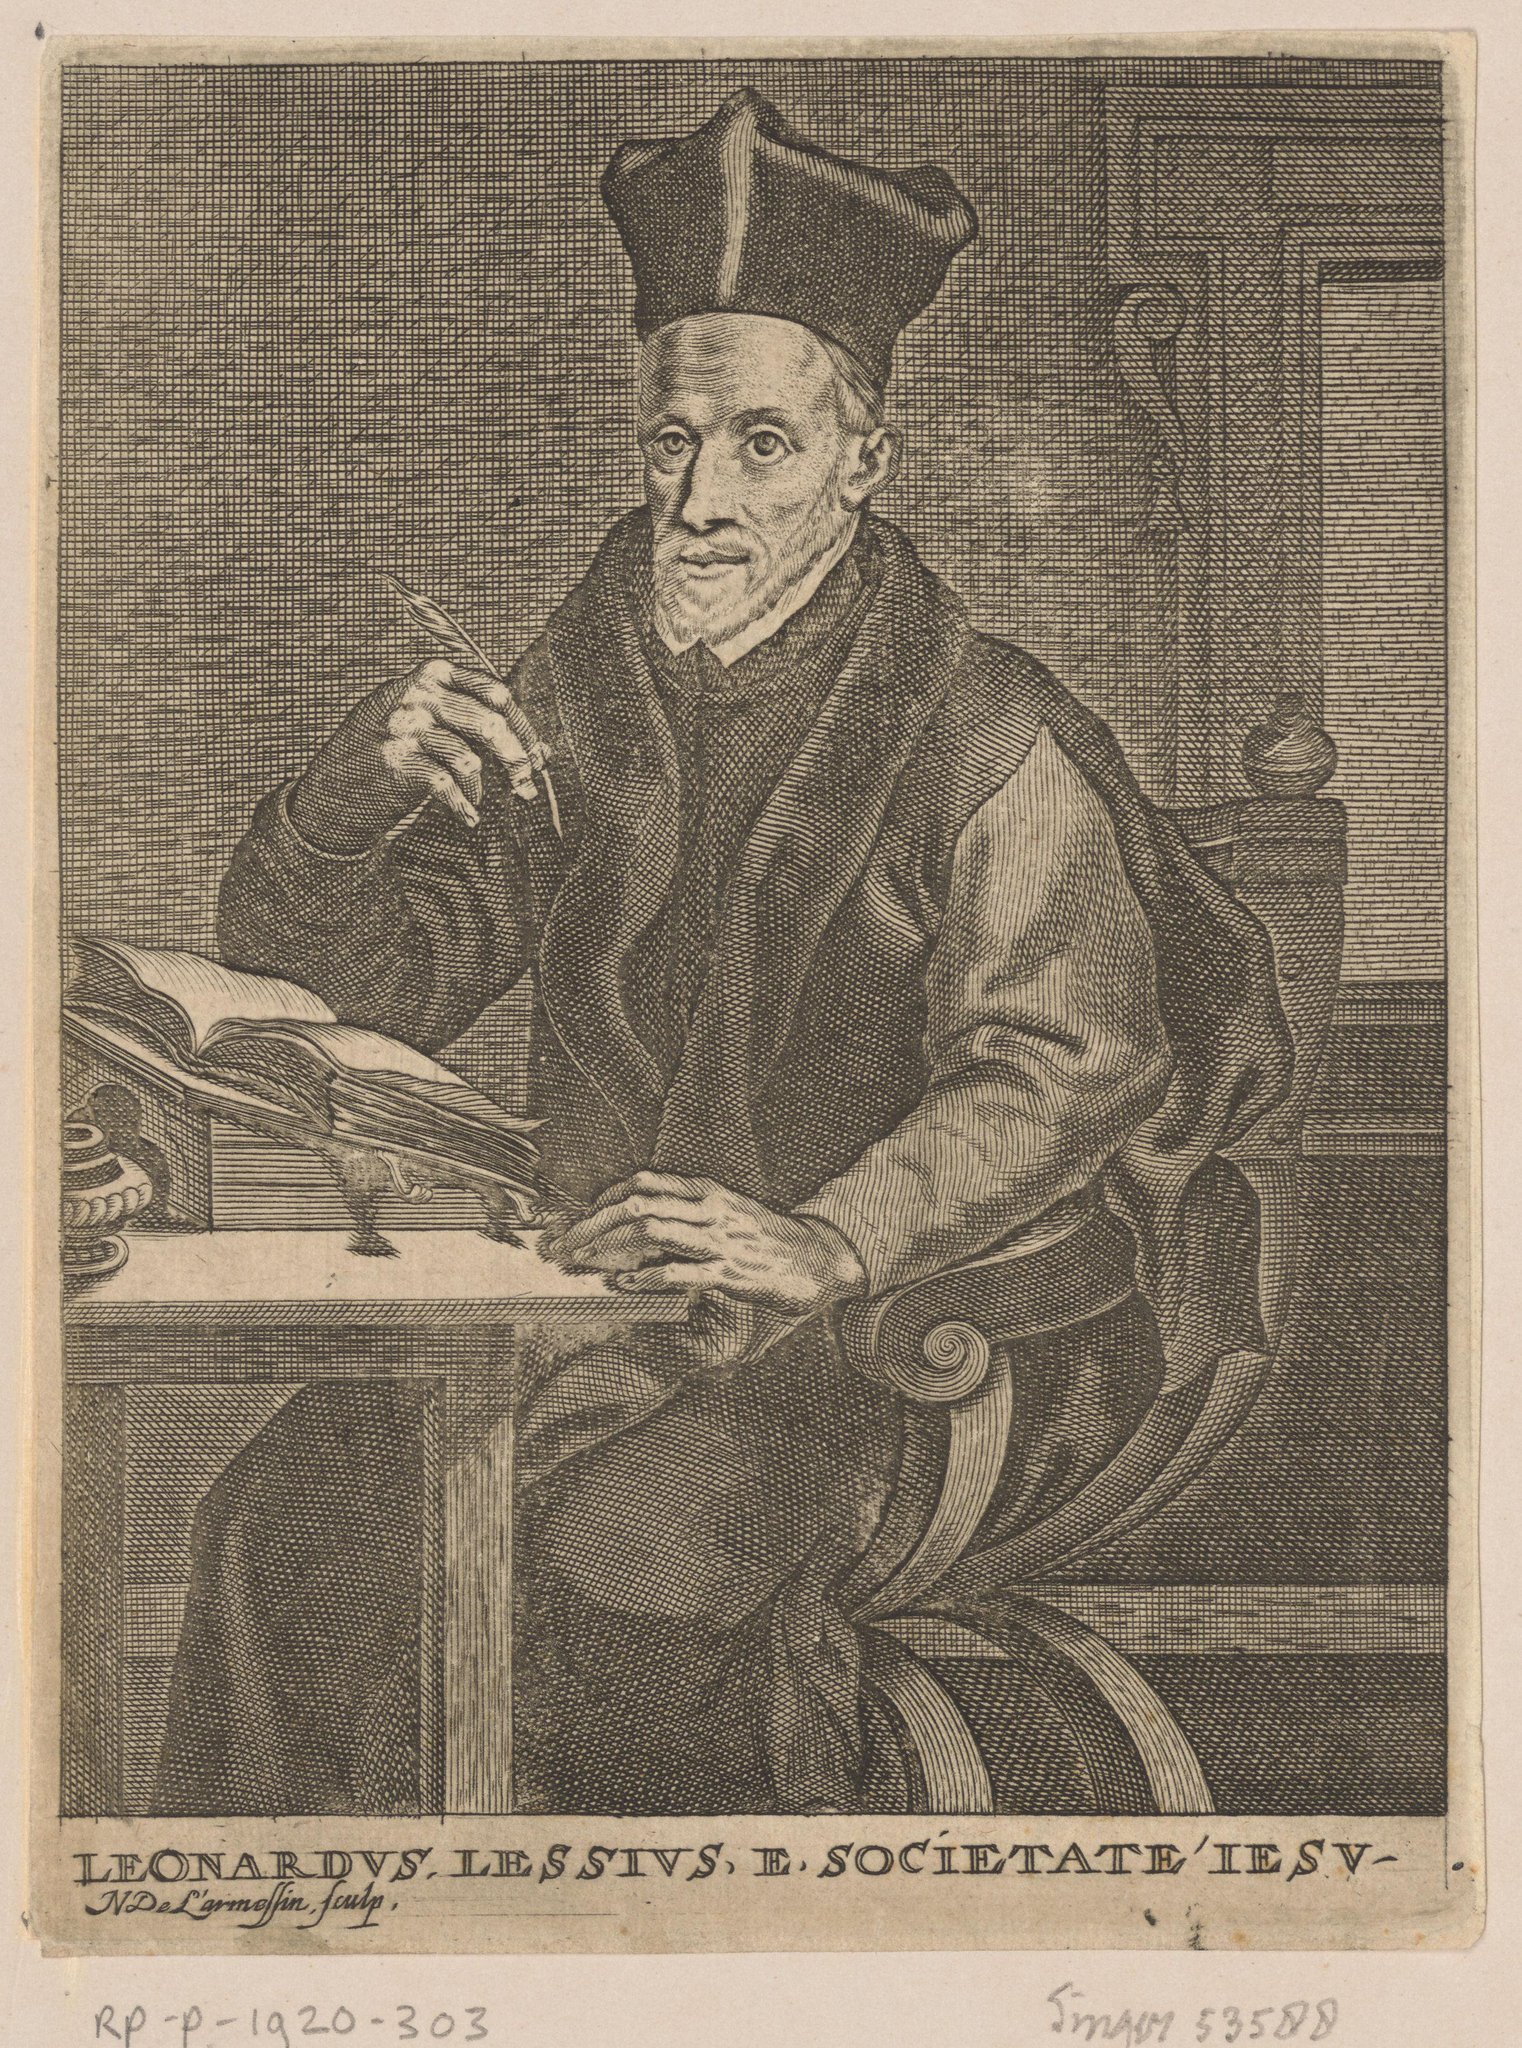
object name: print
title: Portret van Leonardus Lessius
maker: nicolas de larmessin (i)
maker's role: print maker, publisher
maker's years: 1632-1694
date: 1682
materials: paper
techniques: engraving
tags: louvain, writing-table, writing-desk, theologian, historical persons, book - mm - book open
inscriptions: collector's mark: Lugt 2228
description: Prent waarschijnlijk uit: Bullart, Isaac. Académie des Sciences et Arts contenant les vies et éloges his. des hommes illustres qui ont excellé en ces professions depuis environ quatre siècles. Brussel: François Foppens, 1682, dl. 2, p. 59. Het boek werd in 1682 eveneens in Amsterdam uitgegeven door de erfgenamen van Daniel Elzevier.